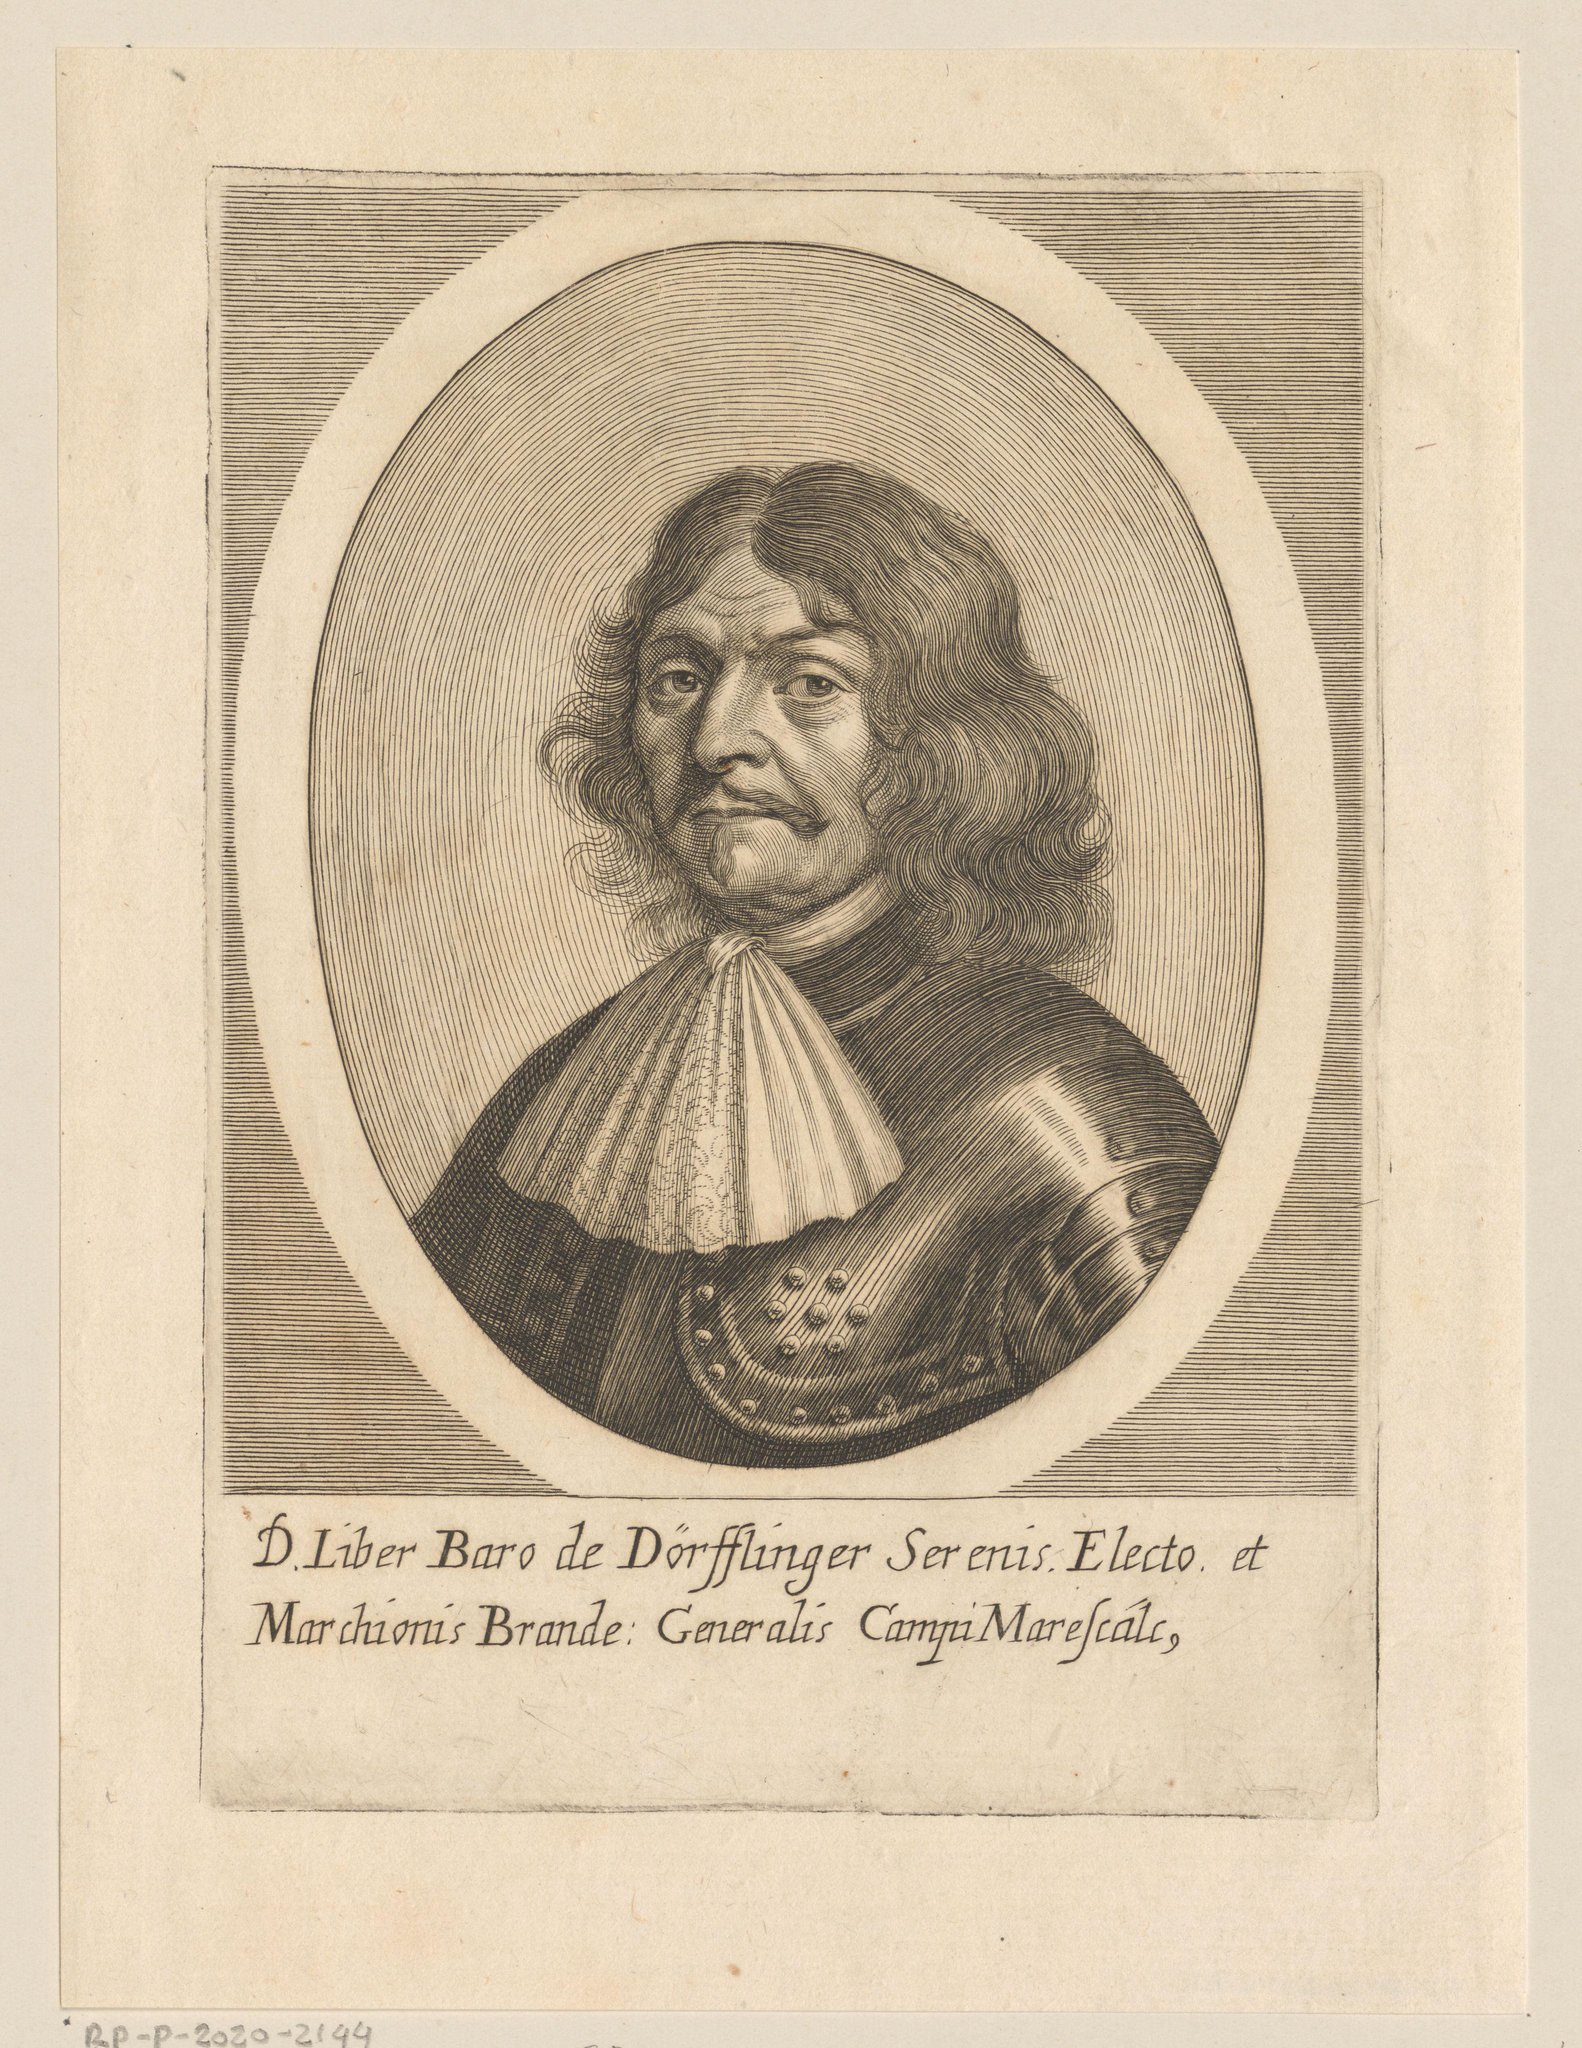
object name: print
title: Portret van Georg, Freiherr von Derfflinger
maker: Anonymous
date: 1674-1749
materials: paper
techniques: aquatint, etching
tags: commander-in-chief, general, marshal, historical persons